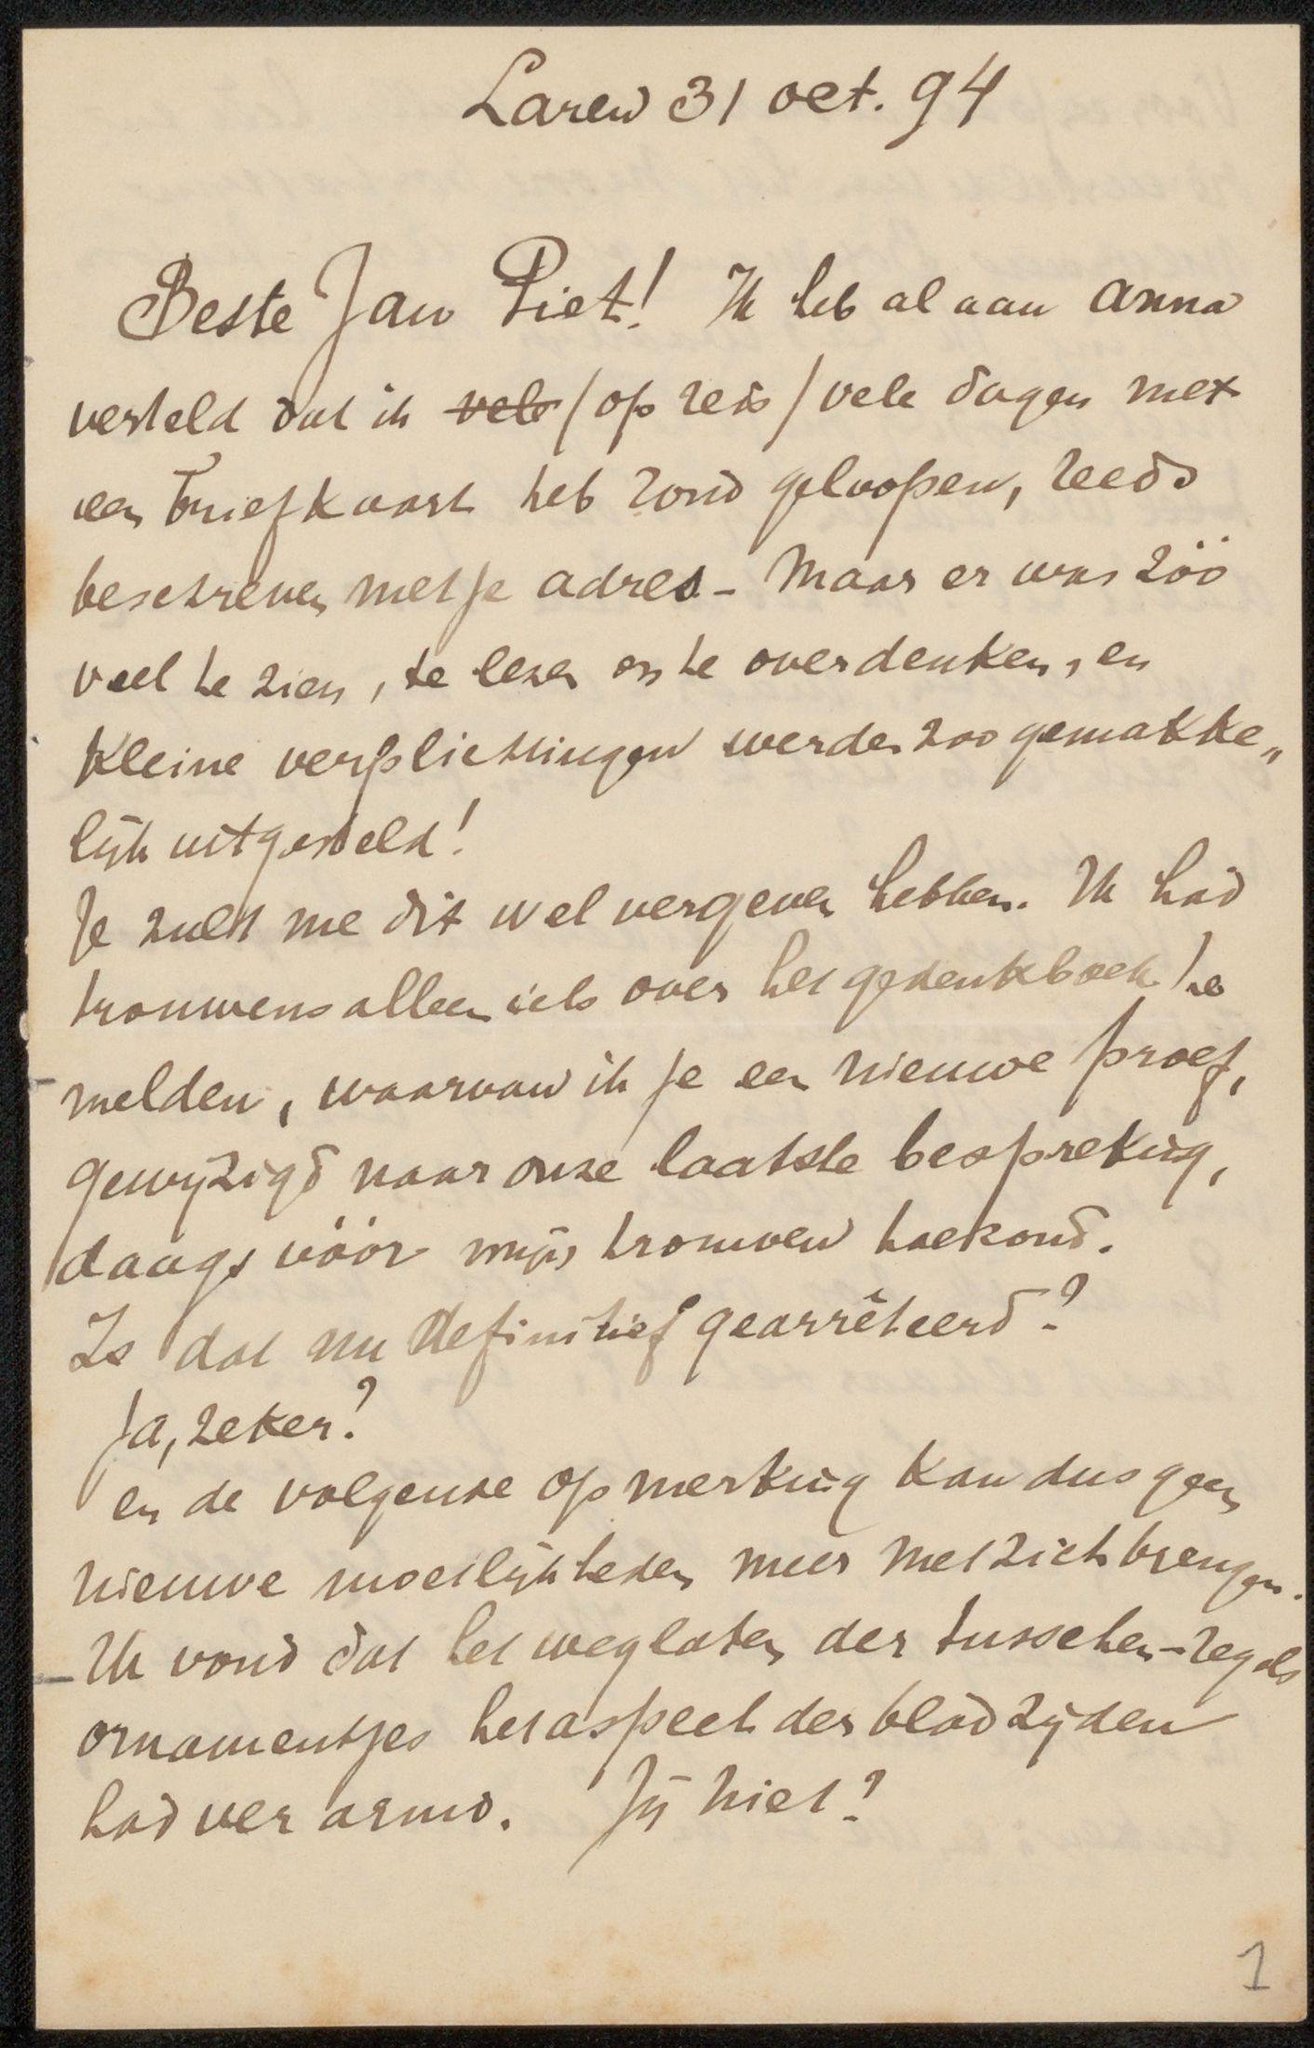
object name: letter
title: Brief aan Jan Veth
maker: antoon derkinderen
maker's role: draughtsman, painter, print maker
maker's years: 1859-1925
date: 1894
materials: ink, paper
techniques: pen, writing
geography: laren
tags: dordrecht, painter, draughtsman, designer, jan veth, utrecht, amsterdam, print maker, johanna henriëtte besier, wally moes, richard nicolaüs roland holst, applied arts, arts and crafts; industrial design, photography, cinematography, exhibition ~ art, historical persons (portraits and scenes from the life), printed matter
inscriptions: collector's mark: ‘RPK’